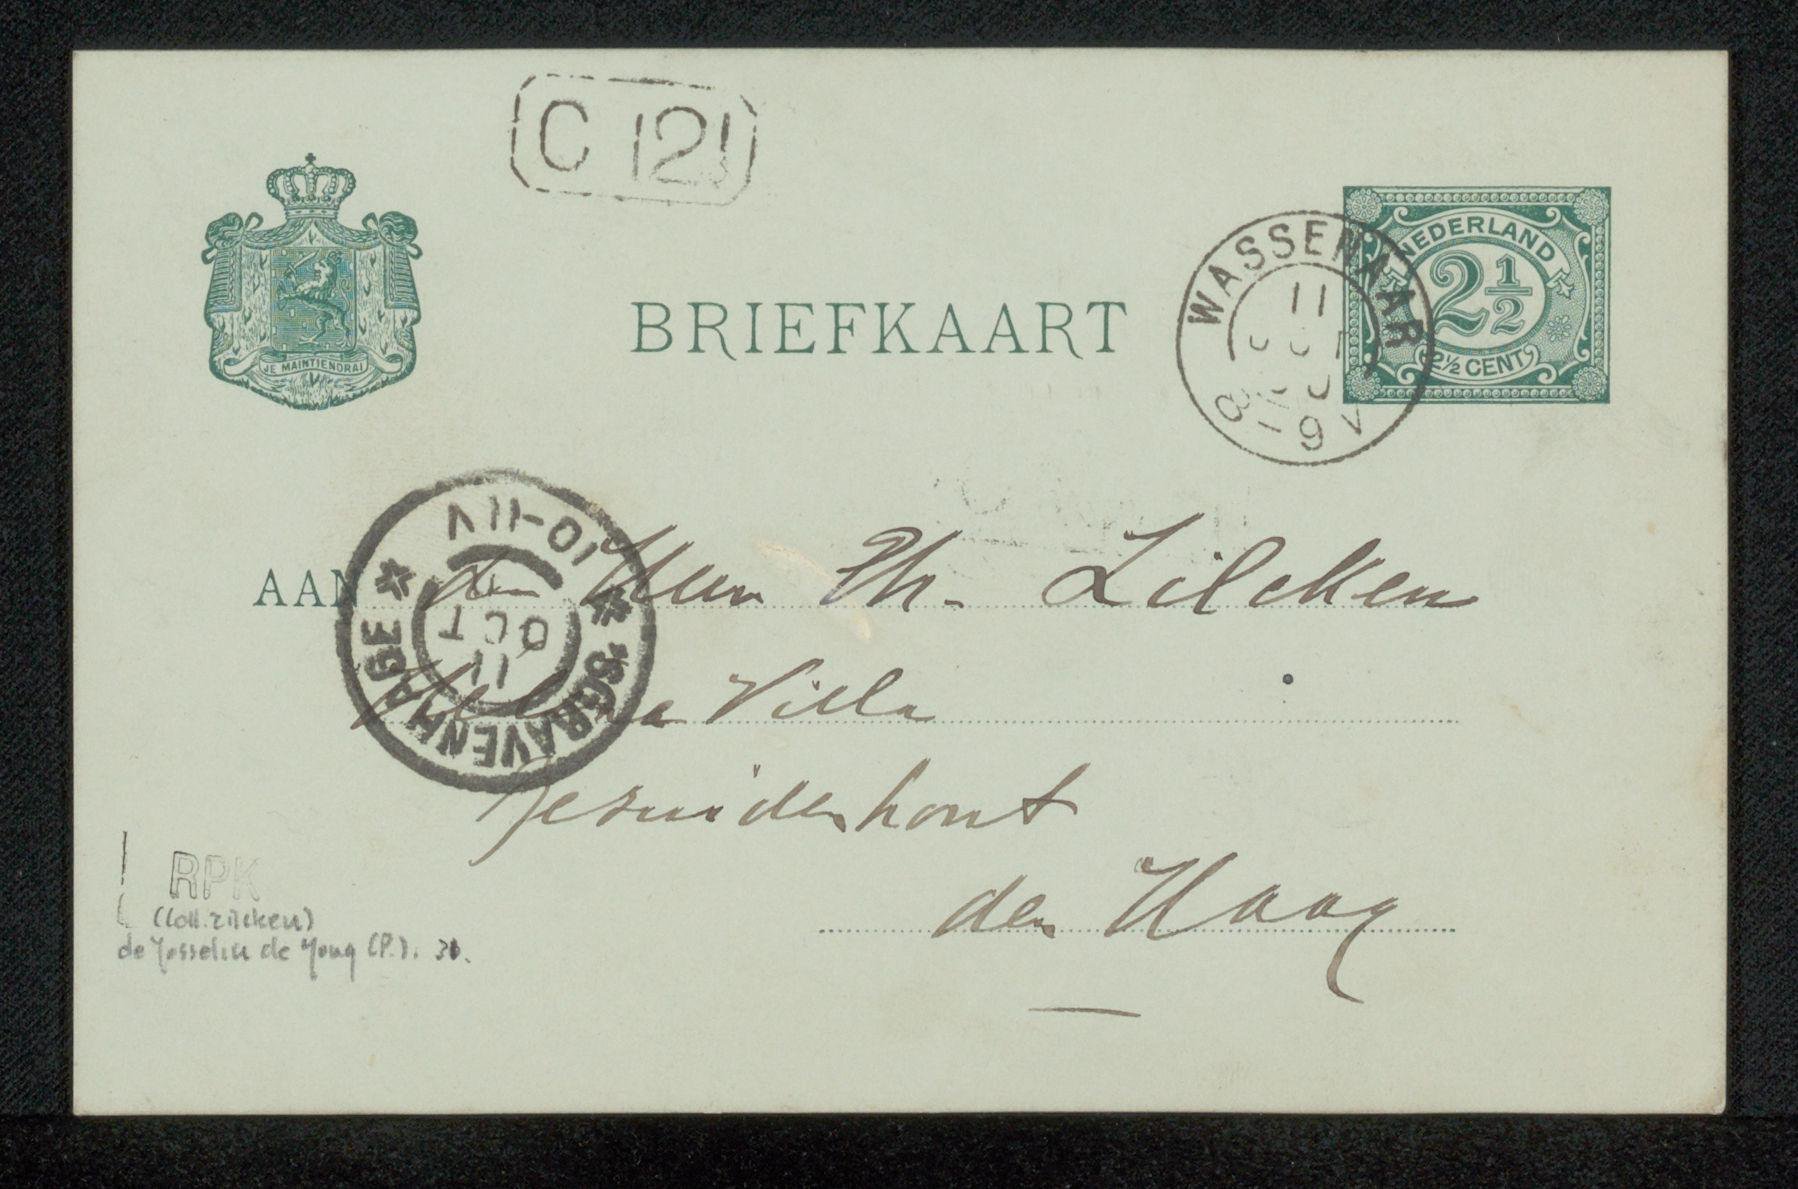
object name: postcard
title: Briefkaart aan Philip Zilcken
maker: pieter de josselin de jong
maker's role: draughtsman, painter, print maker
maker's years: 1861-1906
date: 1900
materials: cardboard, ink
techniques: writing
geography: wassenaar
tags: the hague, philip zilcken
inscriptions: collector's mark: ‘RPK’